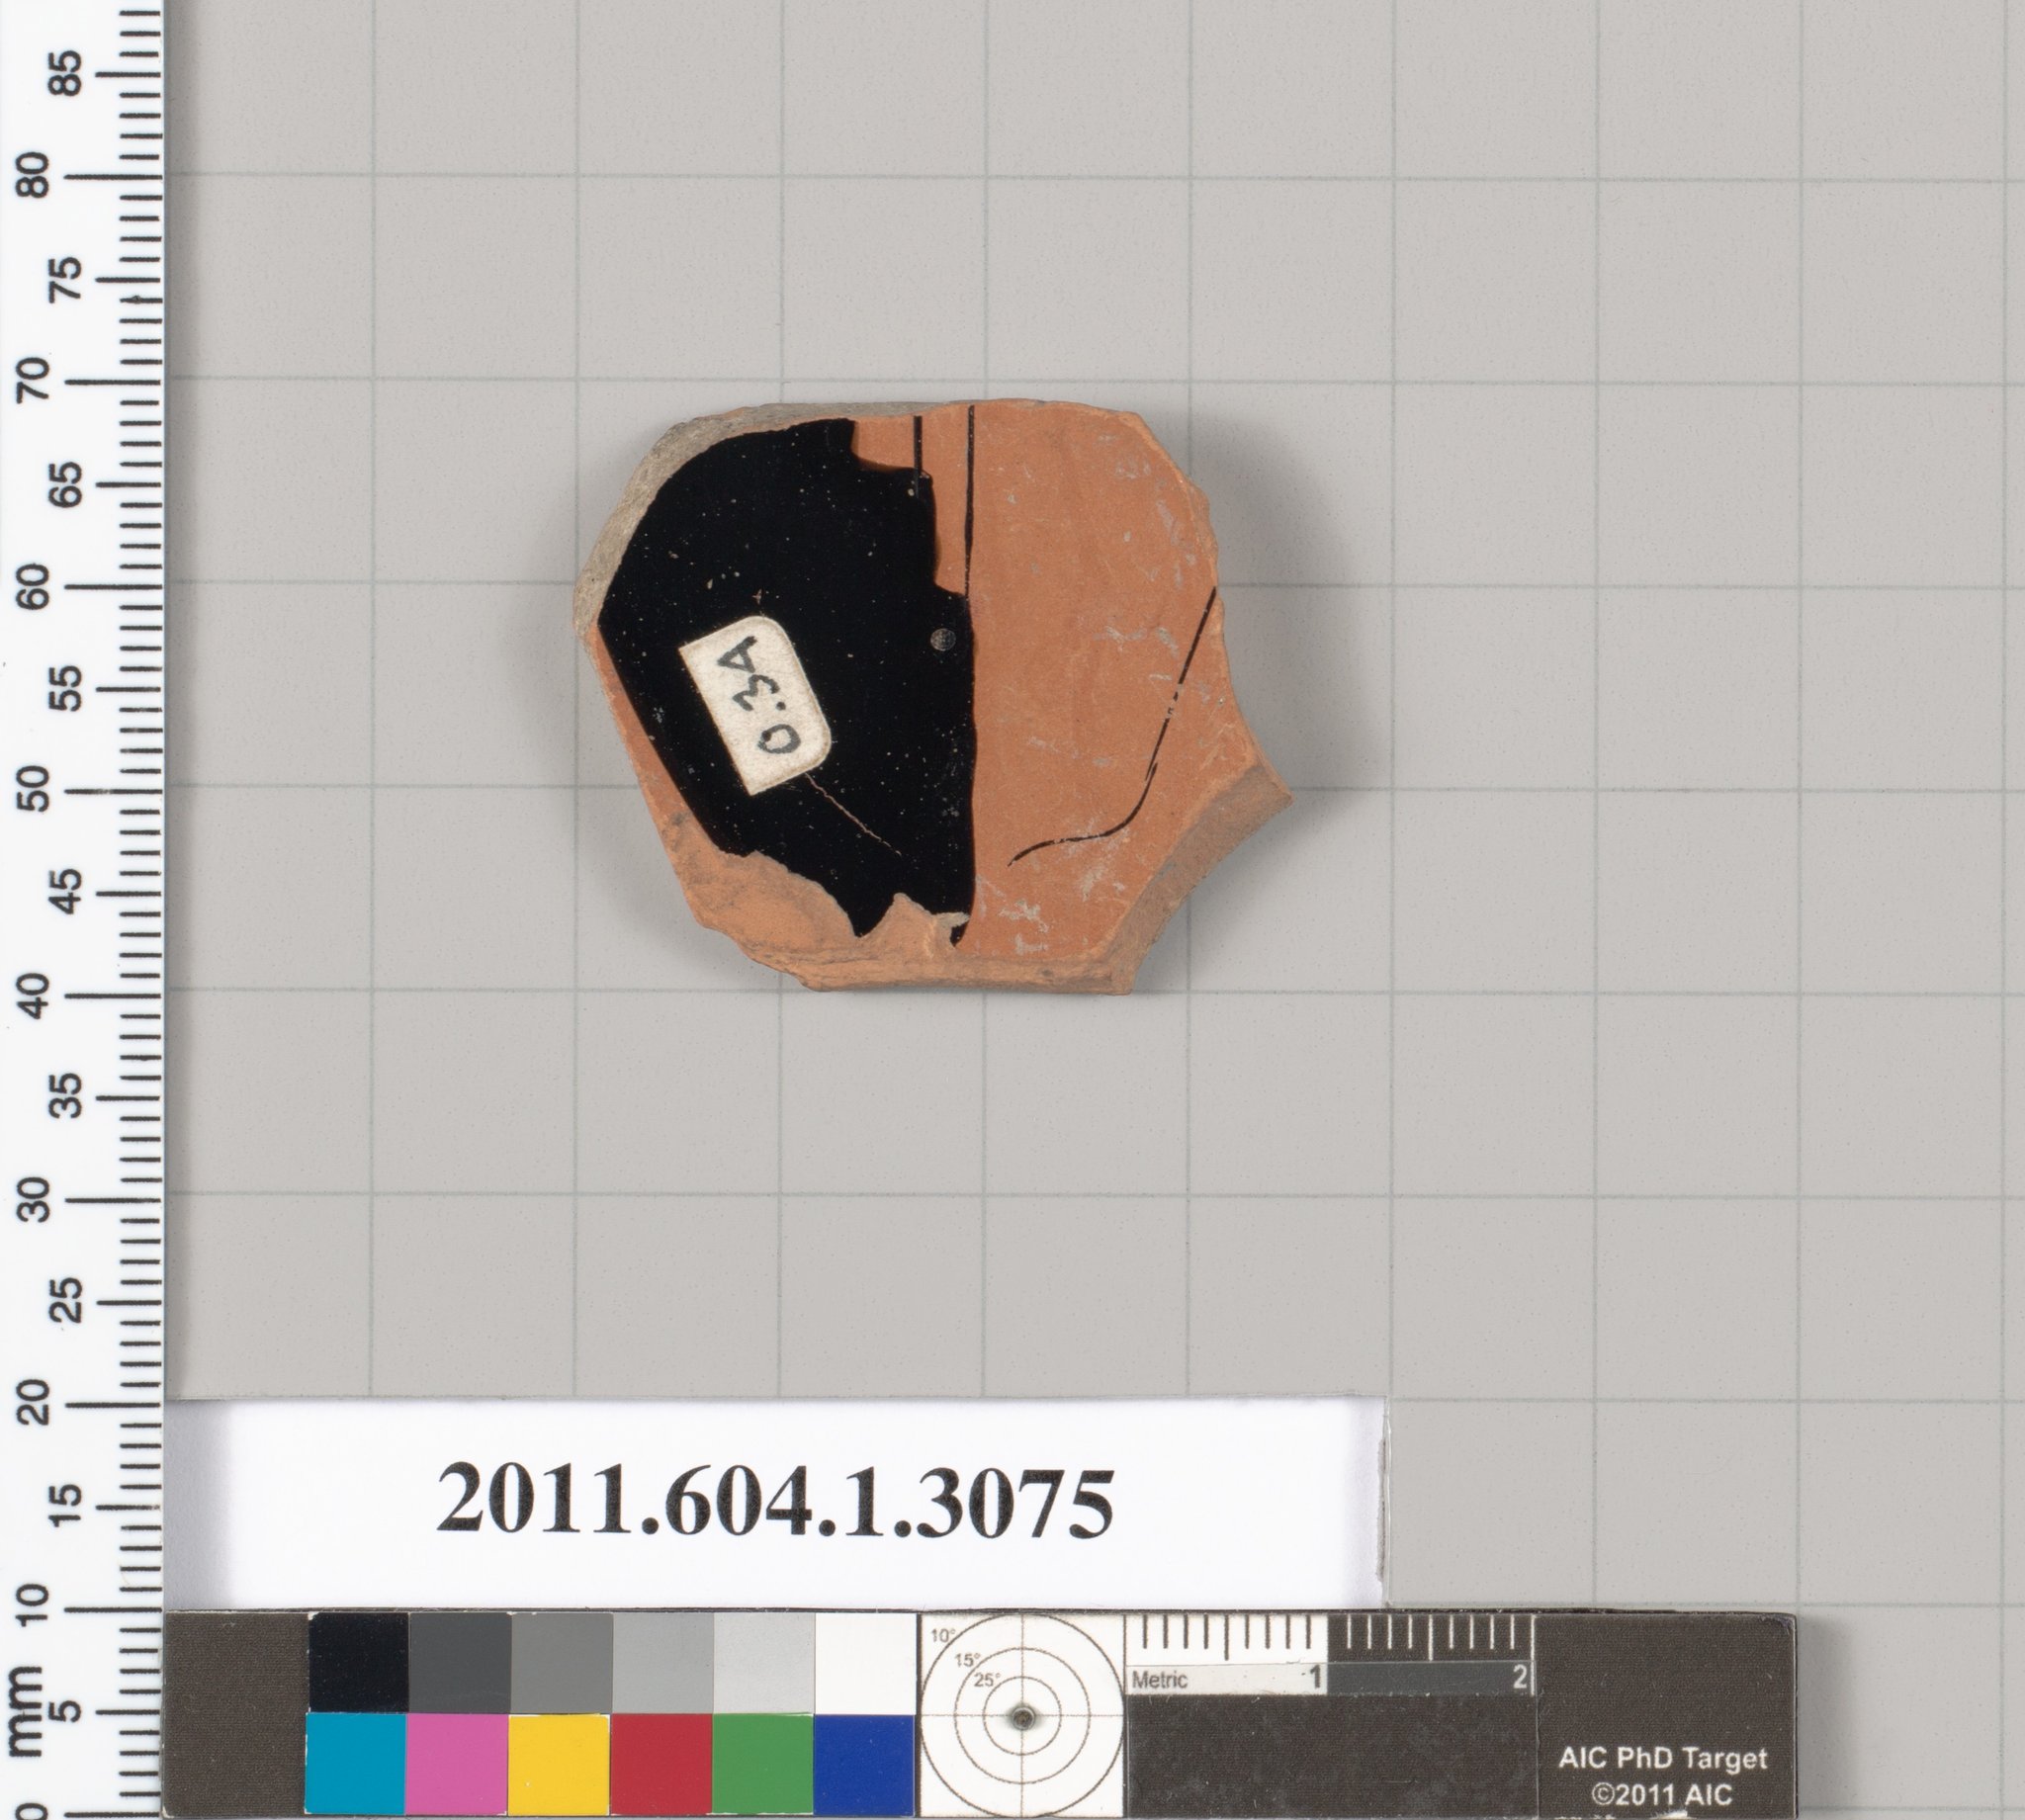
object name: kylix fragment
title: Terracotta fragment of a kylix (drinking cup)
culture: greek, attic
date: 475-451 BCE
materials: terracotta